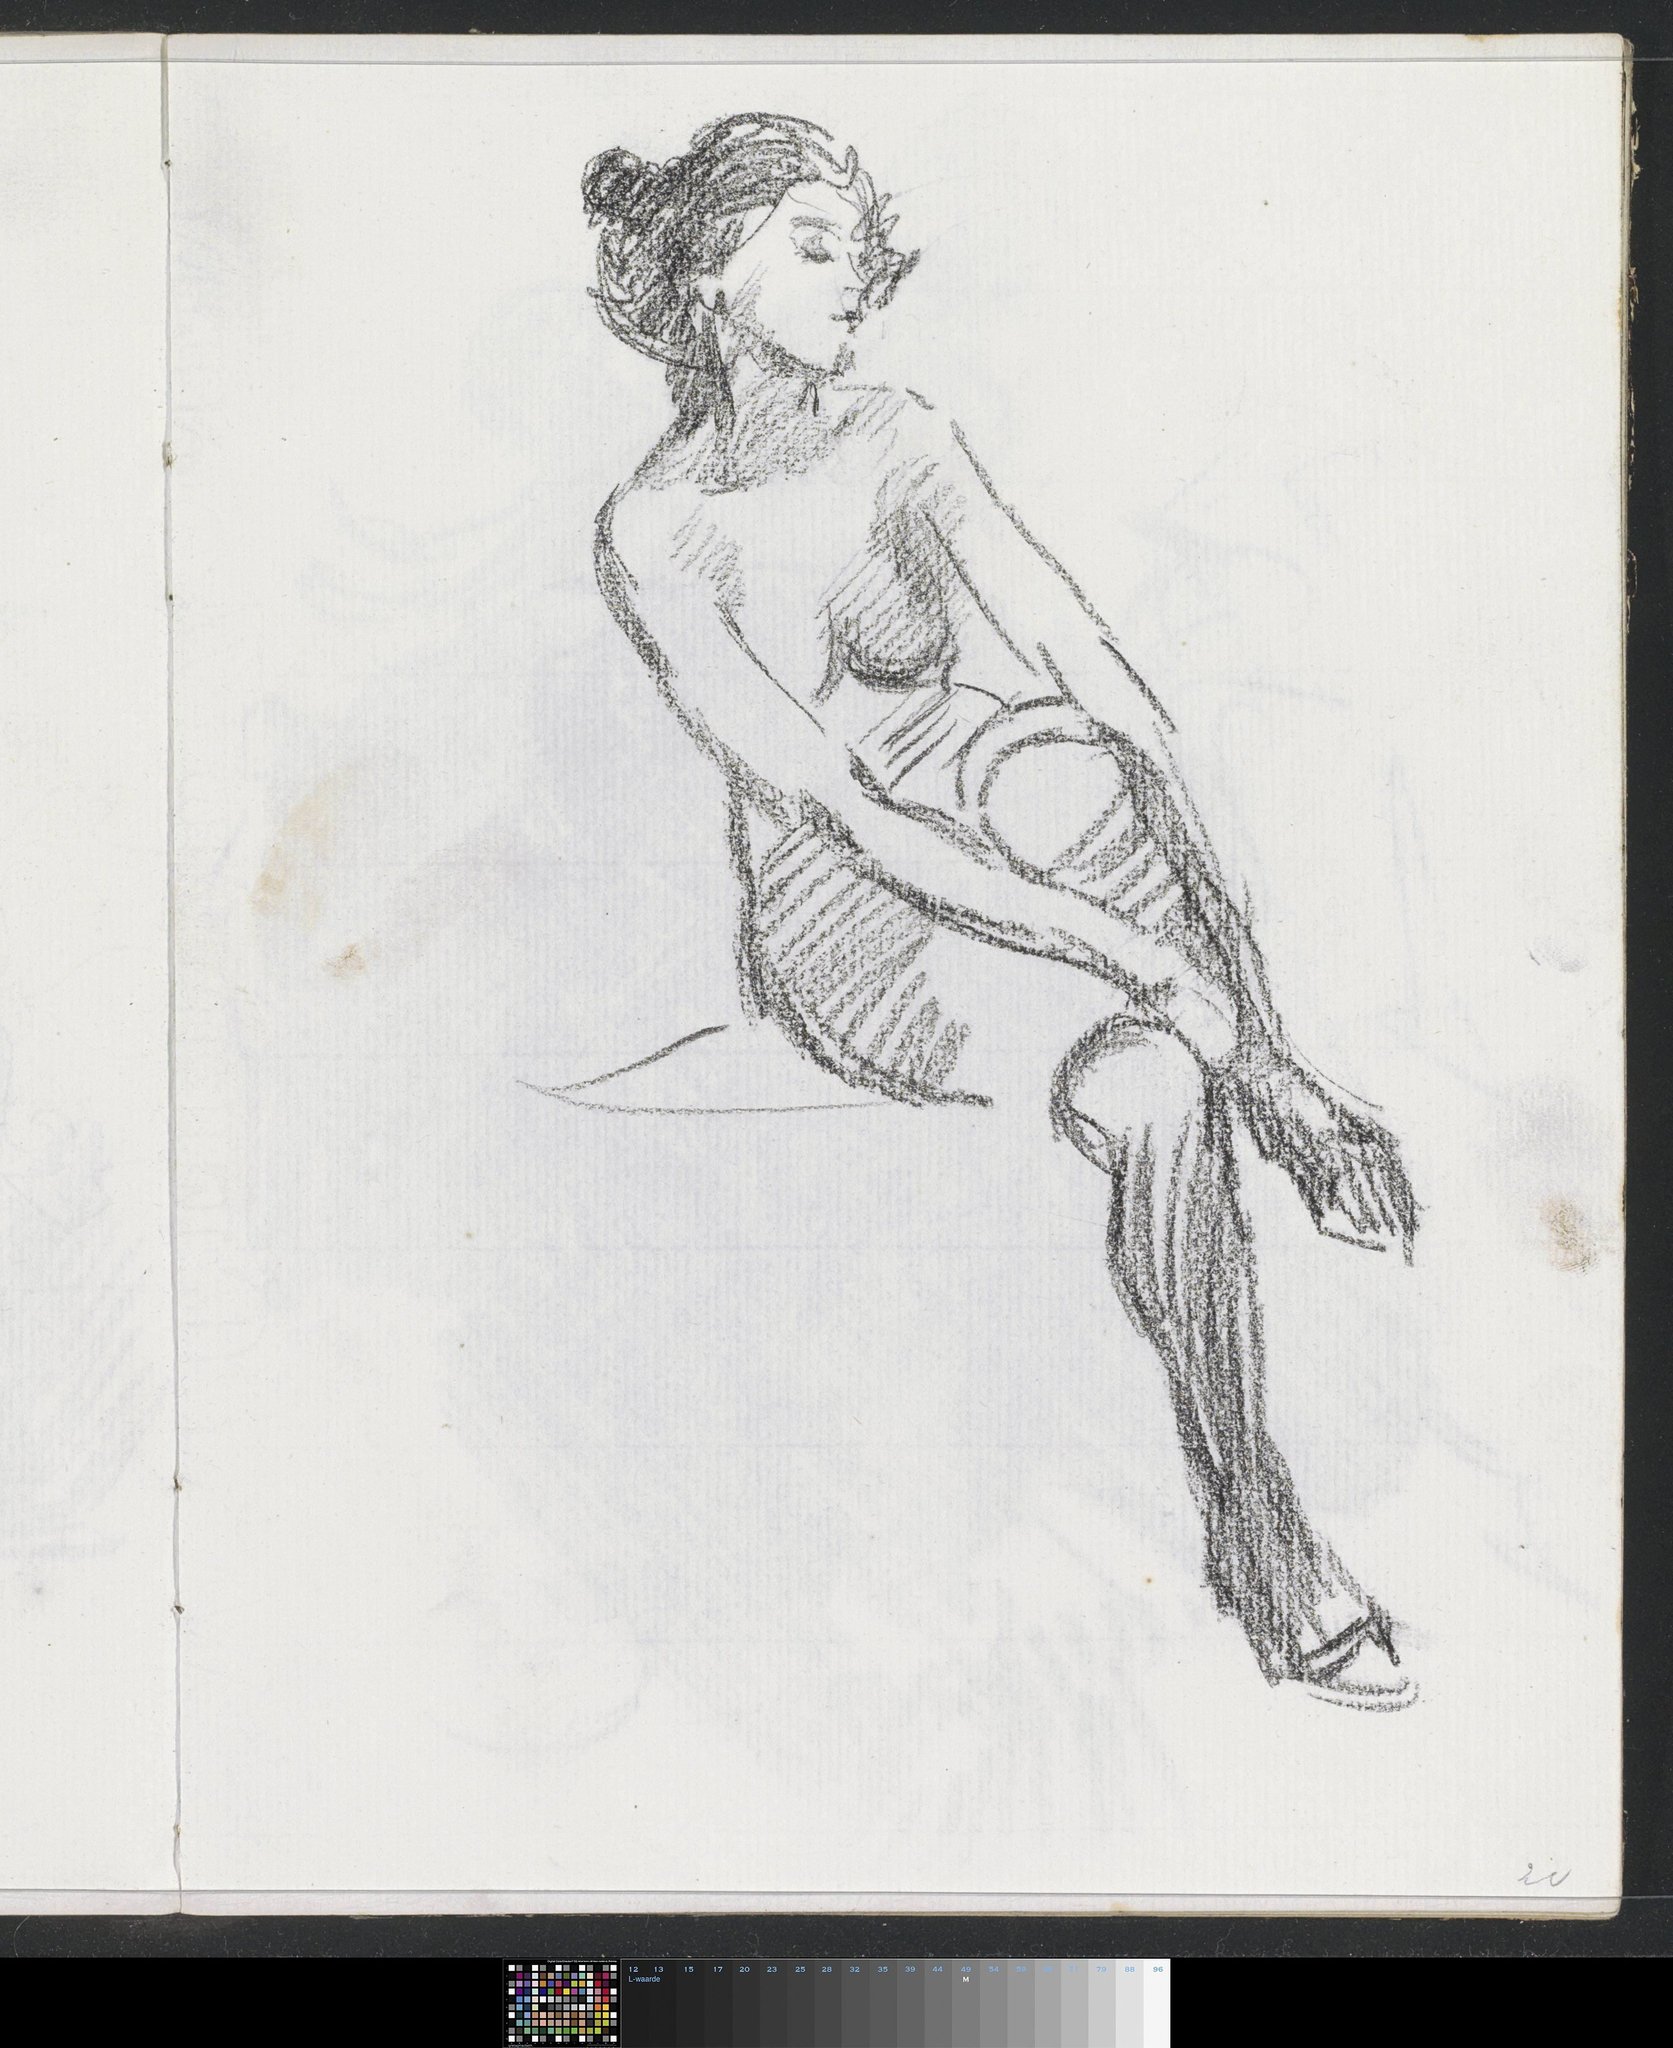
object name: sketchbook leaf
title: Seated Female Nude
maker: isaac israels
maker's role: draughtsman, painter, print maker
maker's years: 1865-1934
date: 1875-1934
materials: chalk, paper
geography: the hague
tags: sitting figure - aa - female human figure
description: Met opgetrokken linkerbeen. Blad 20 recto uit schetsboek XIII met 25 bladen.